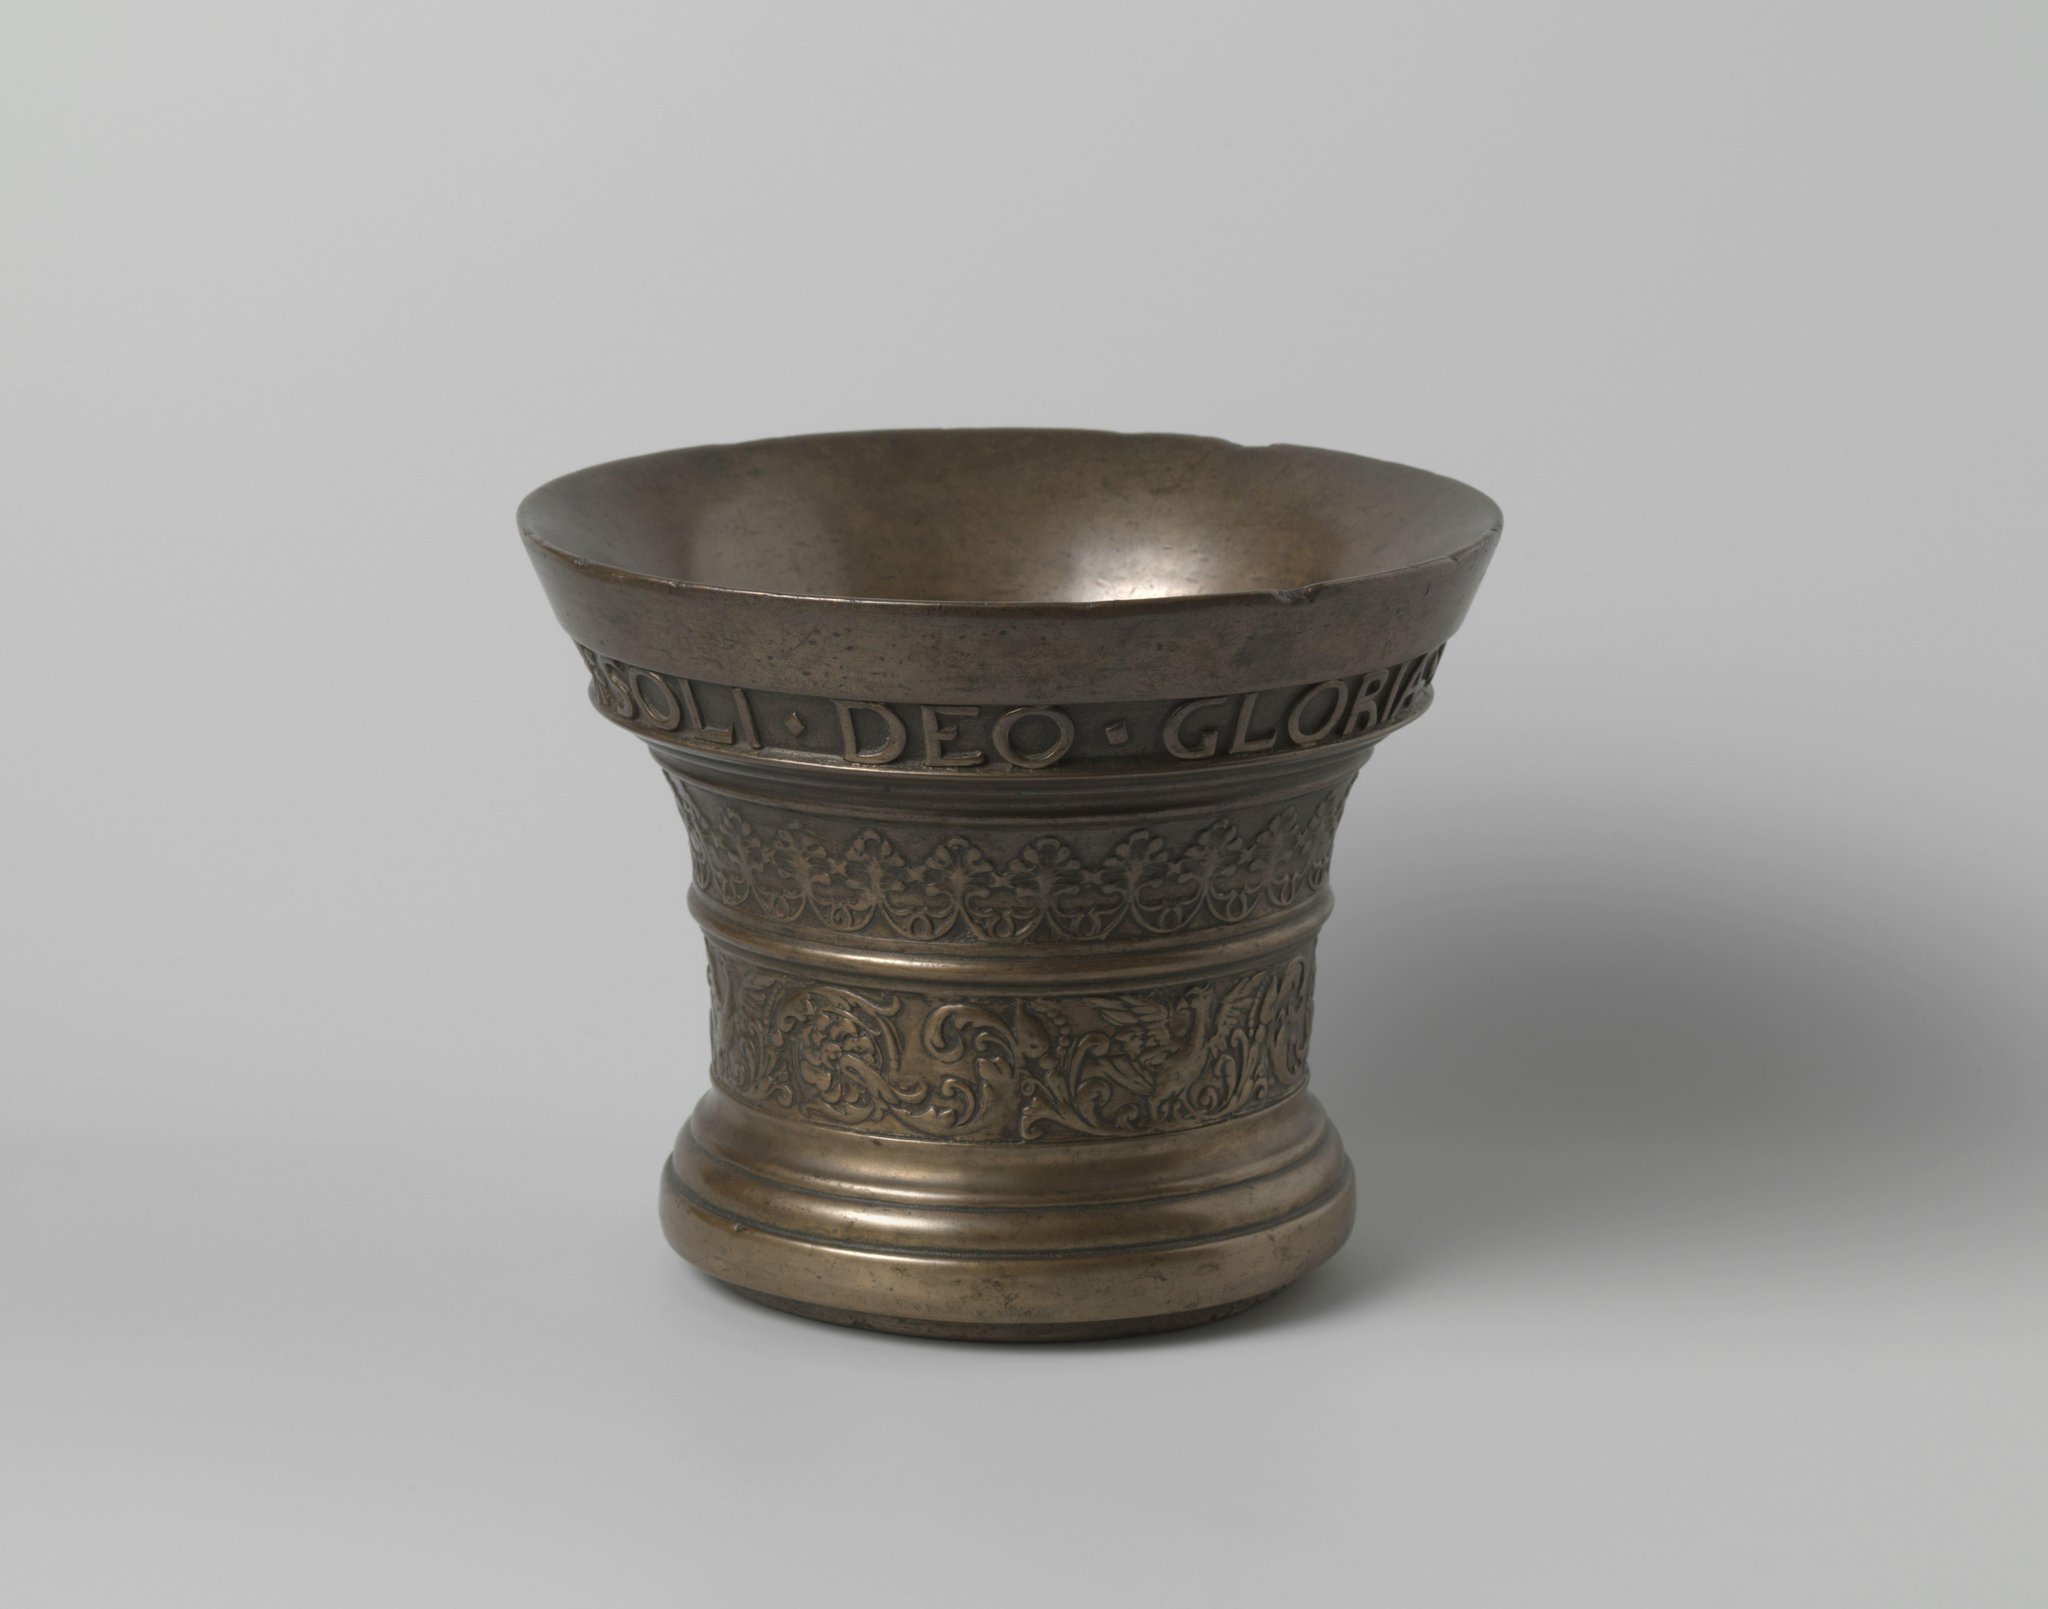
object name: mortar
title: Mortar and Pestle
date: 1637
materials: bronze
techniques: casting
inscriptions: inscription: ‘SOLI.DEO.GLORIA.OVWERROGGE.FECIT.1637’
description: This mortar is adorned with two friezes. The top one consists of stylized flowers, while the bottom one features flowers, foliage motifs, and birds with spread wings. Inscribed in Latin along the top edge is: ‘By the grace of God, Ouderogge made this in 1637.’ The mortar was cast by either Cornelis or his brother Dirk. They also made bells and cannons.